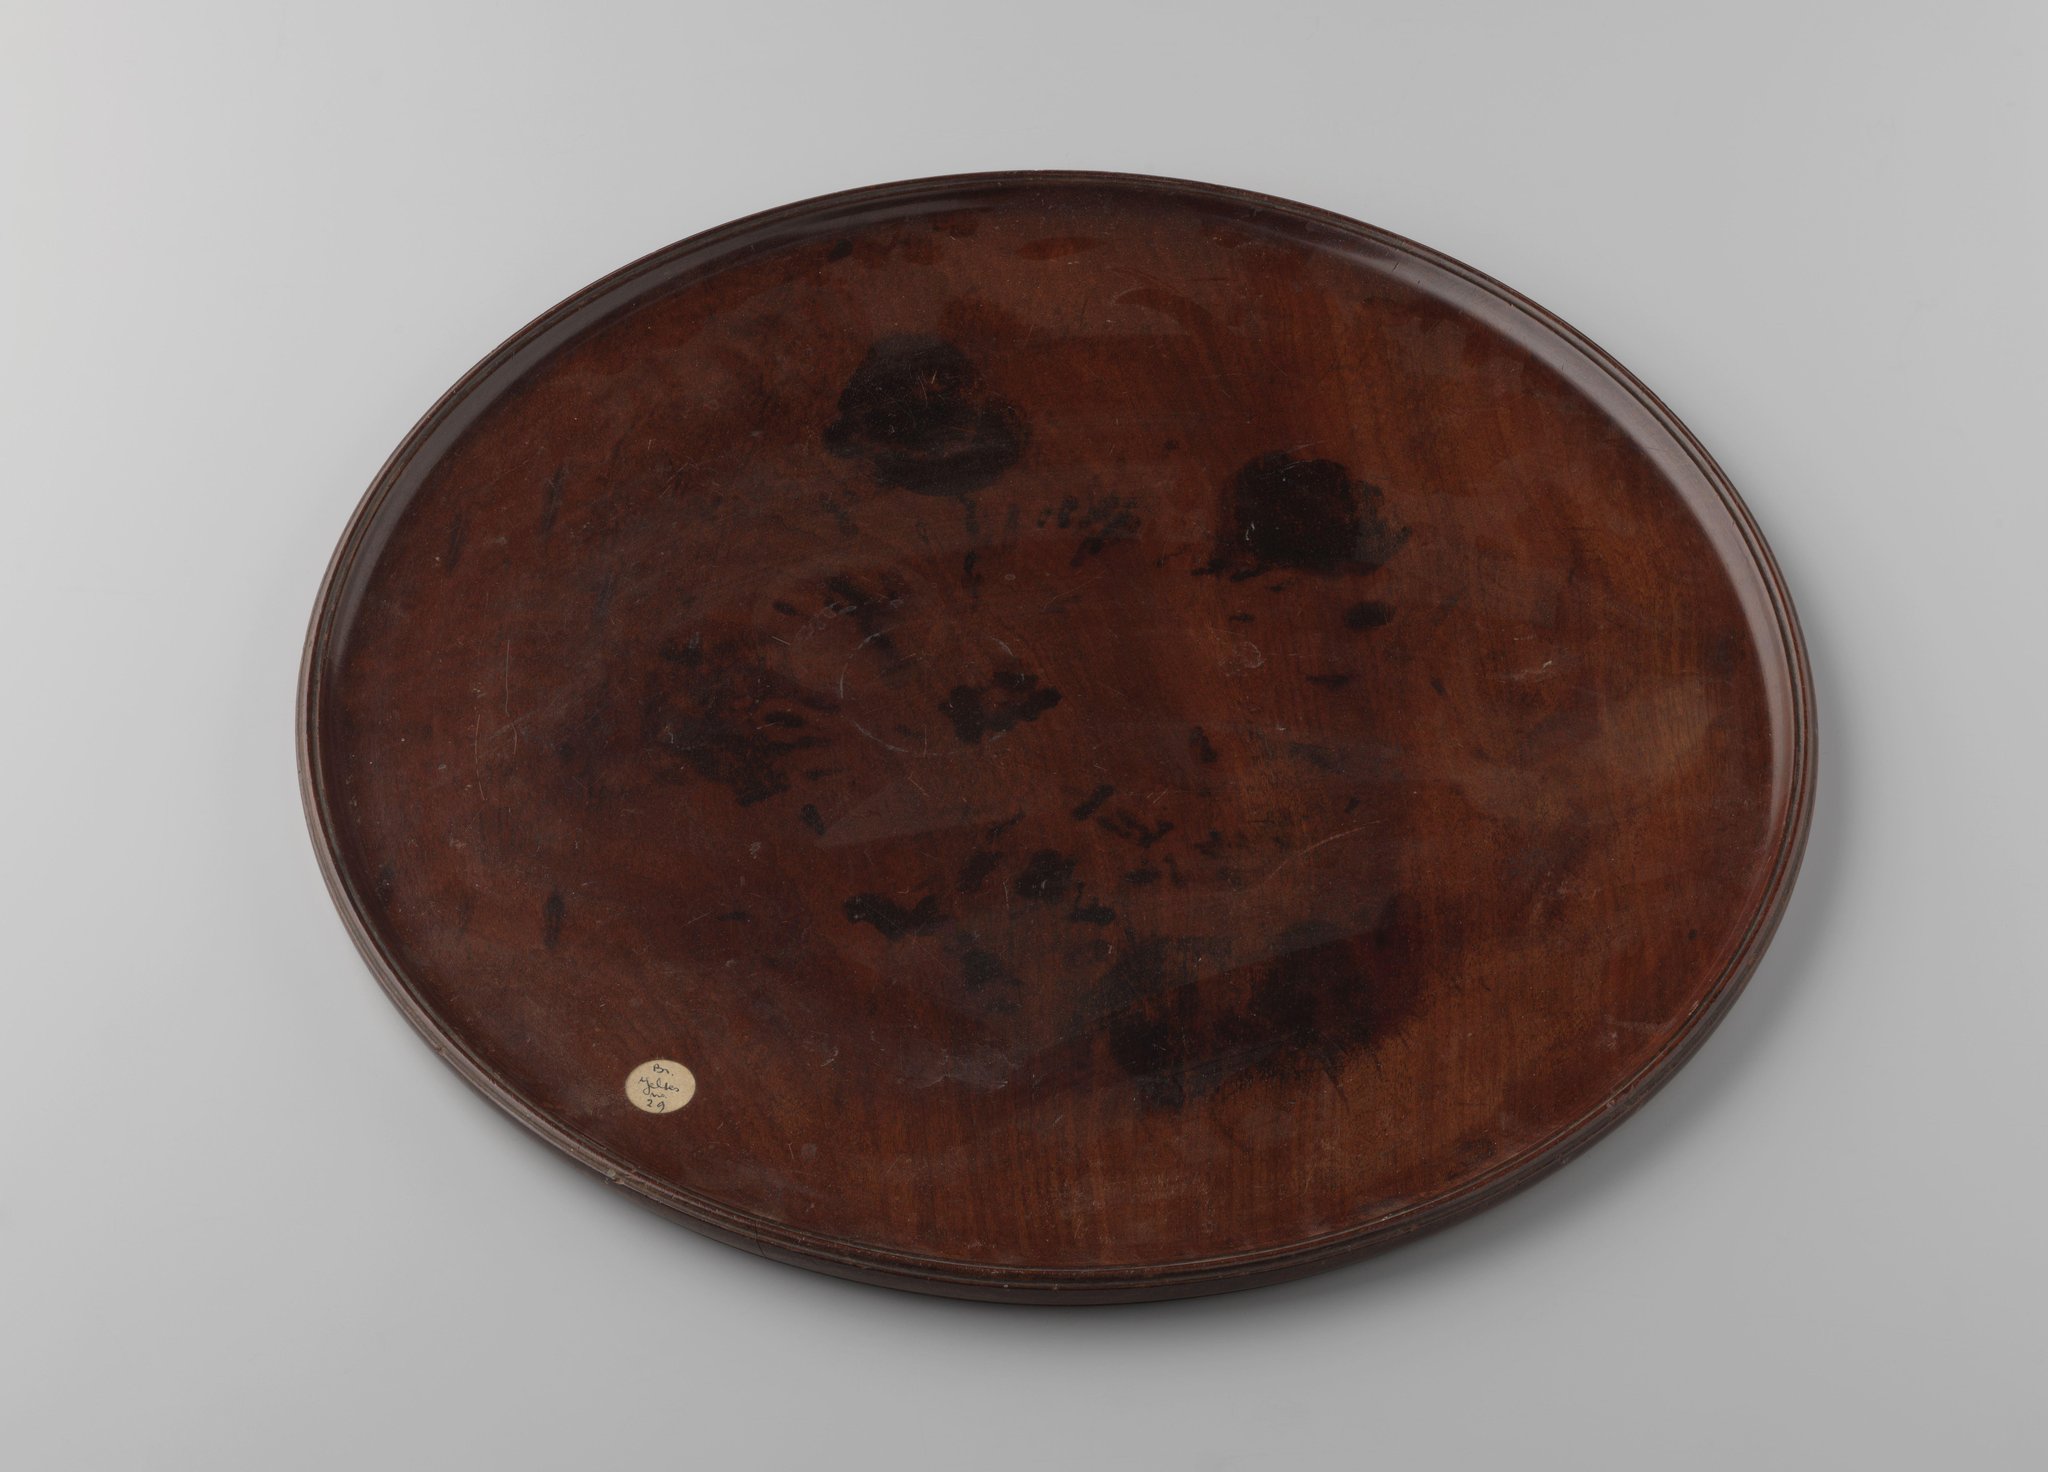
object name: blad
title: Presenteerblad van hout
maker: Anonymous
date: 1912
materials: wood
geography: netherlands